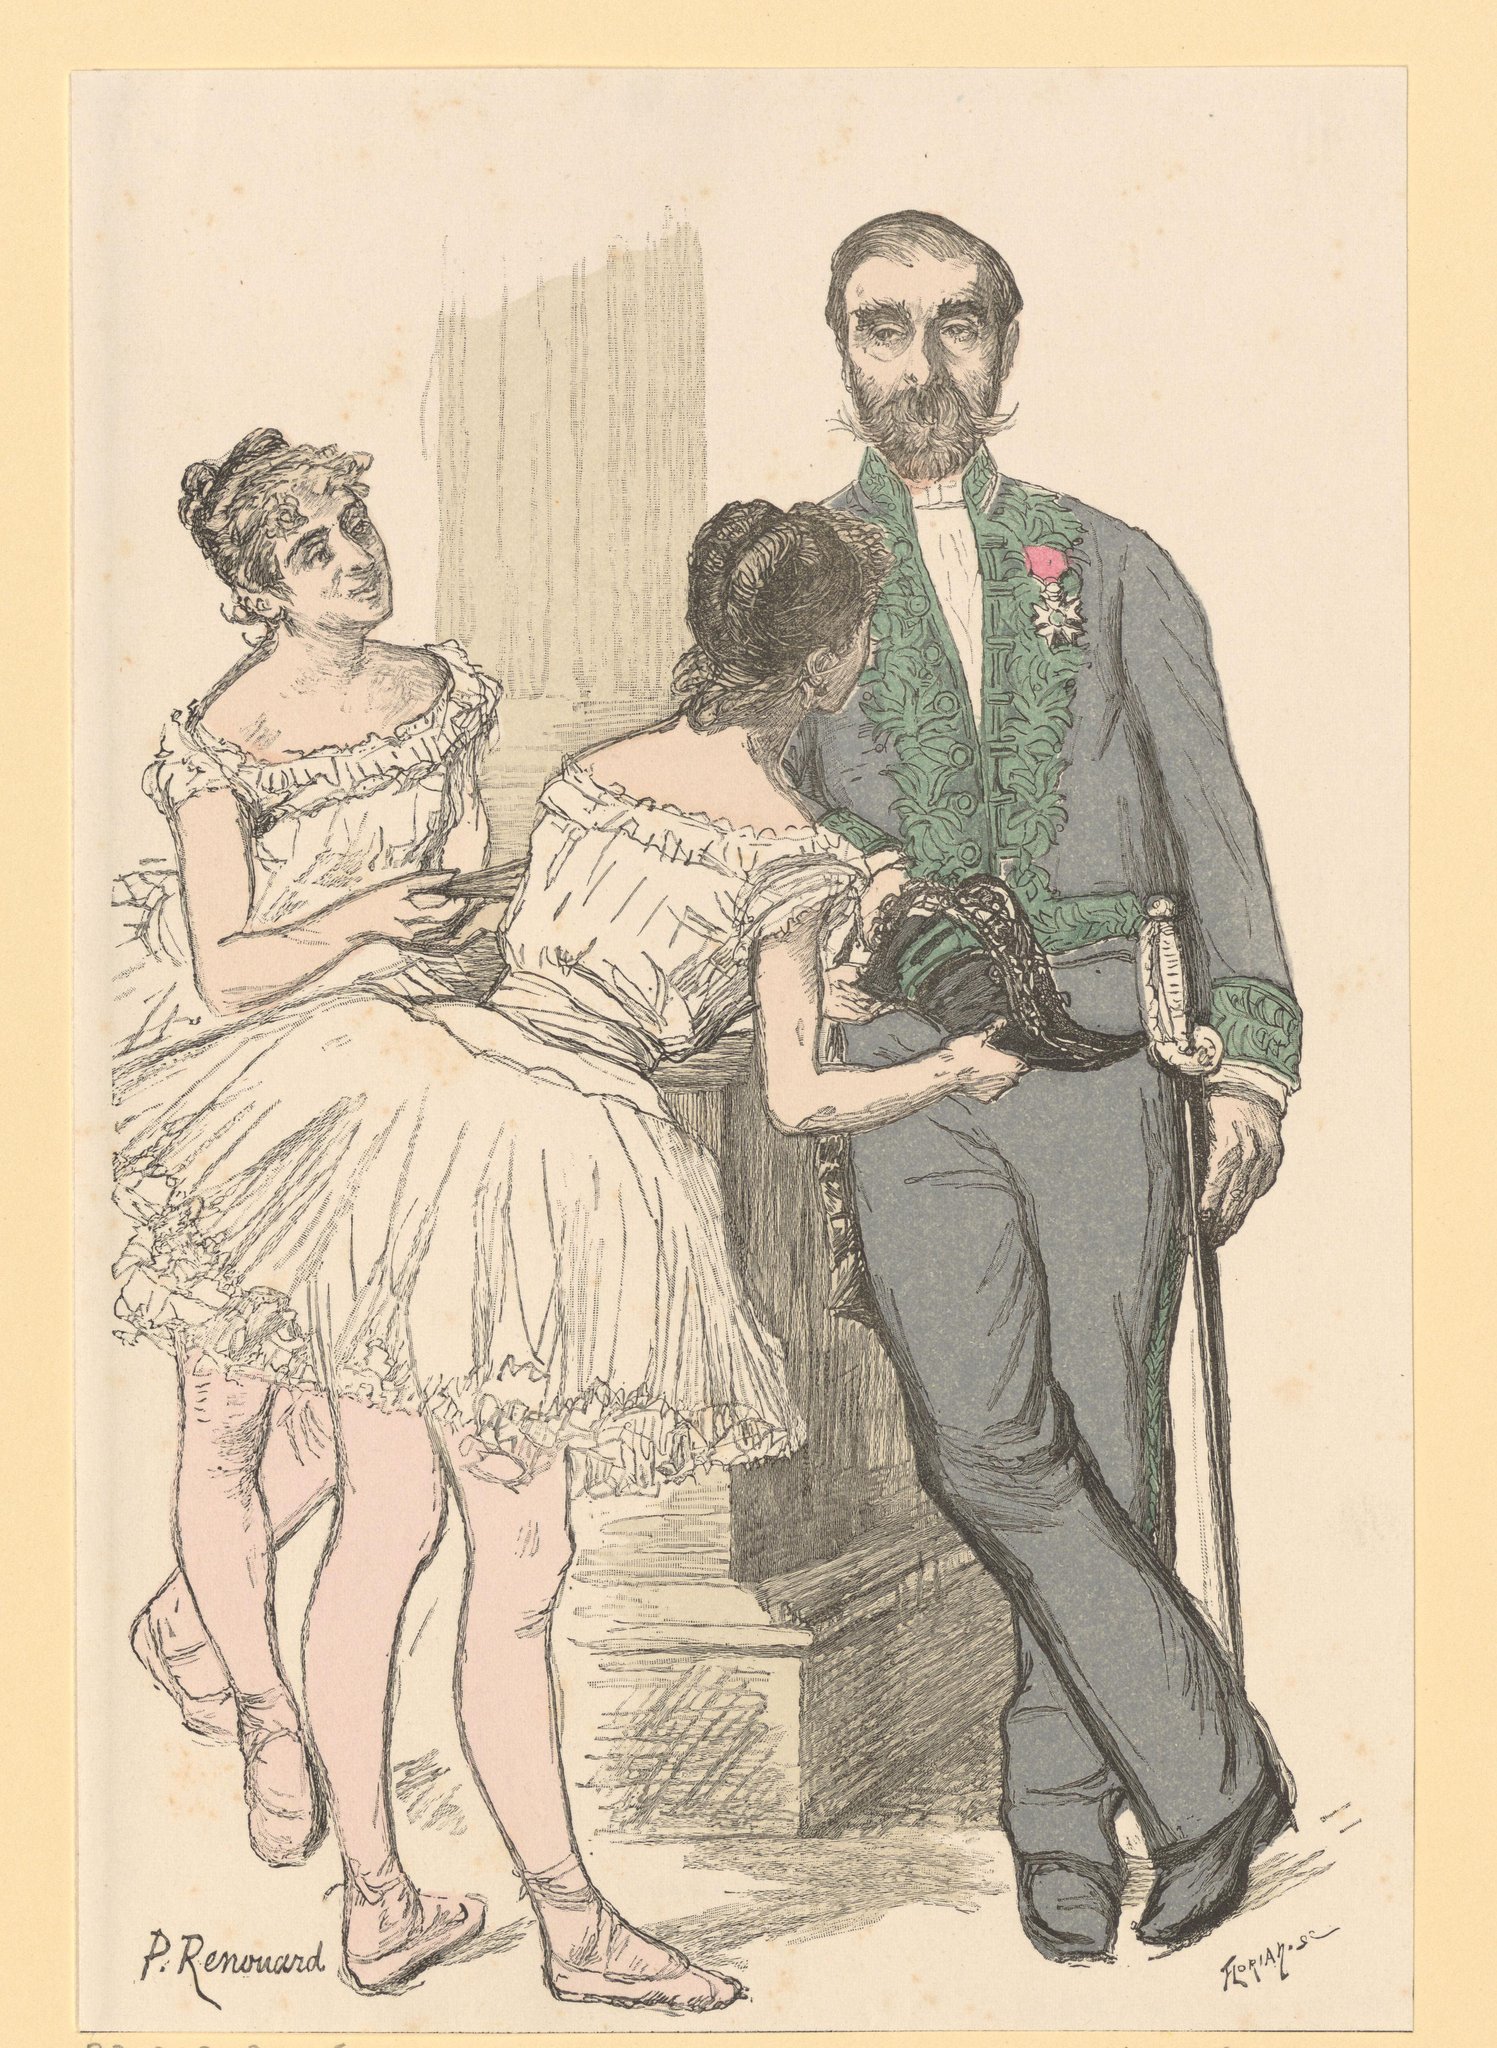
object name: print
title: Portret van Ludovic Halévy en twee balletdanseressen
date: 1885-1886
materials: paper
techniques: lithograph, engraving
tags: historical persons, portrait of a writer, female dancer, ballet dress